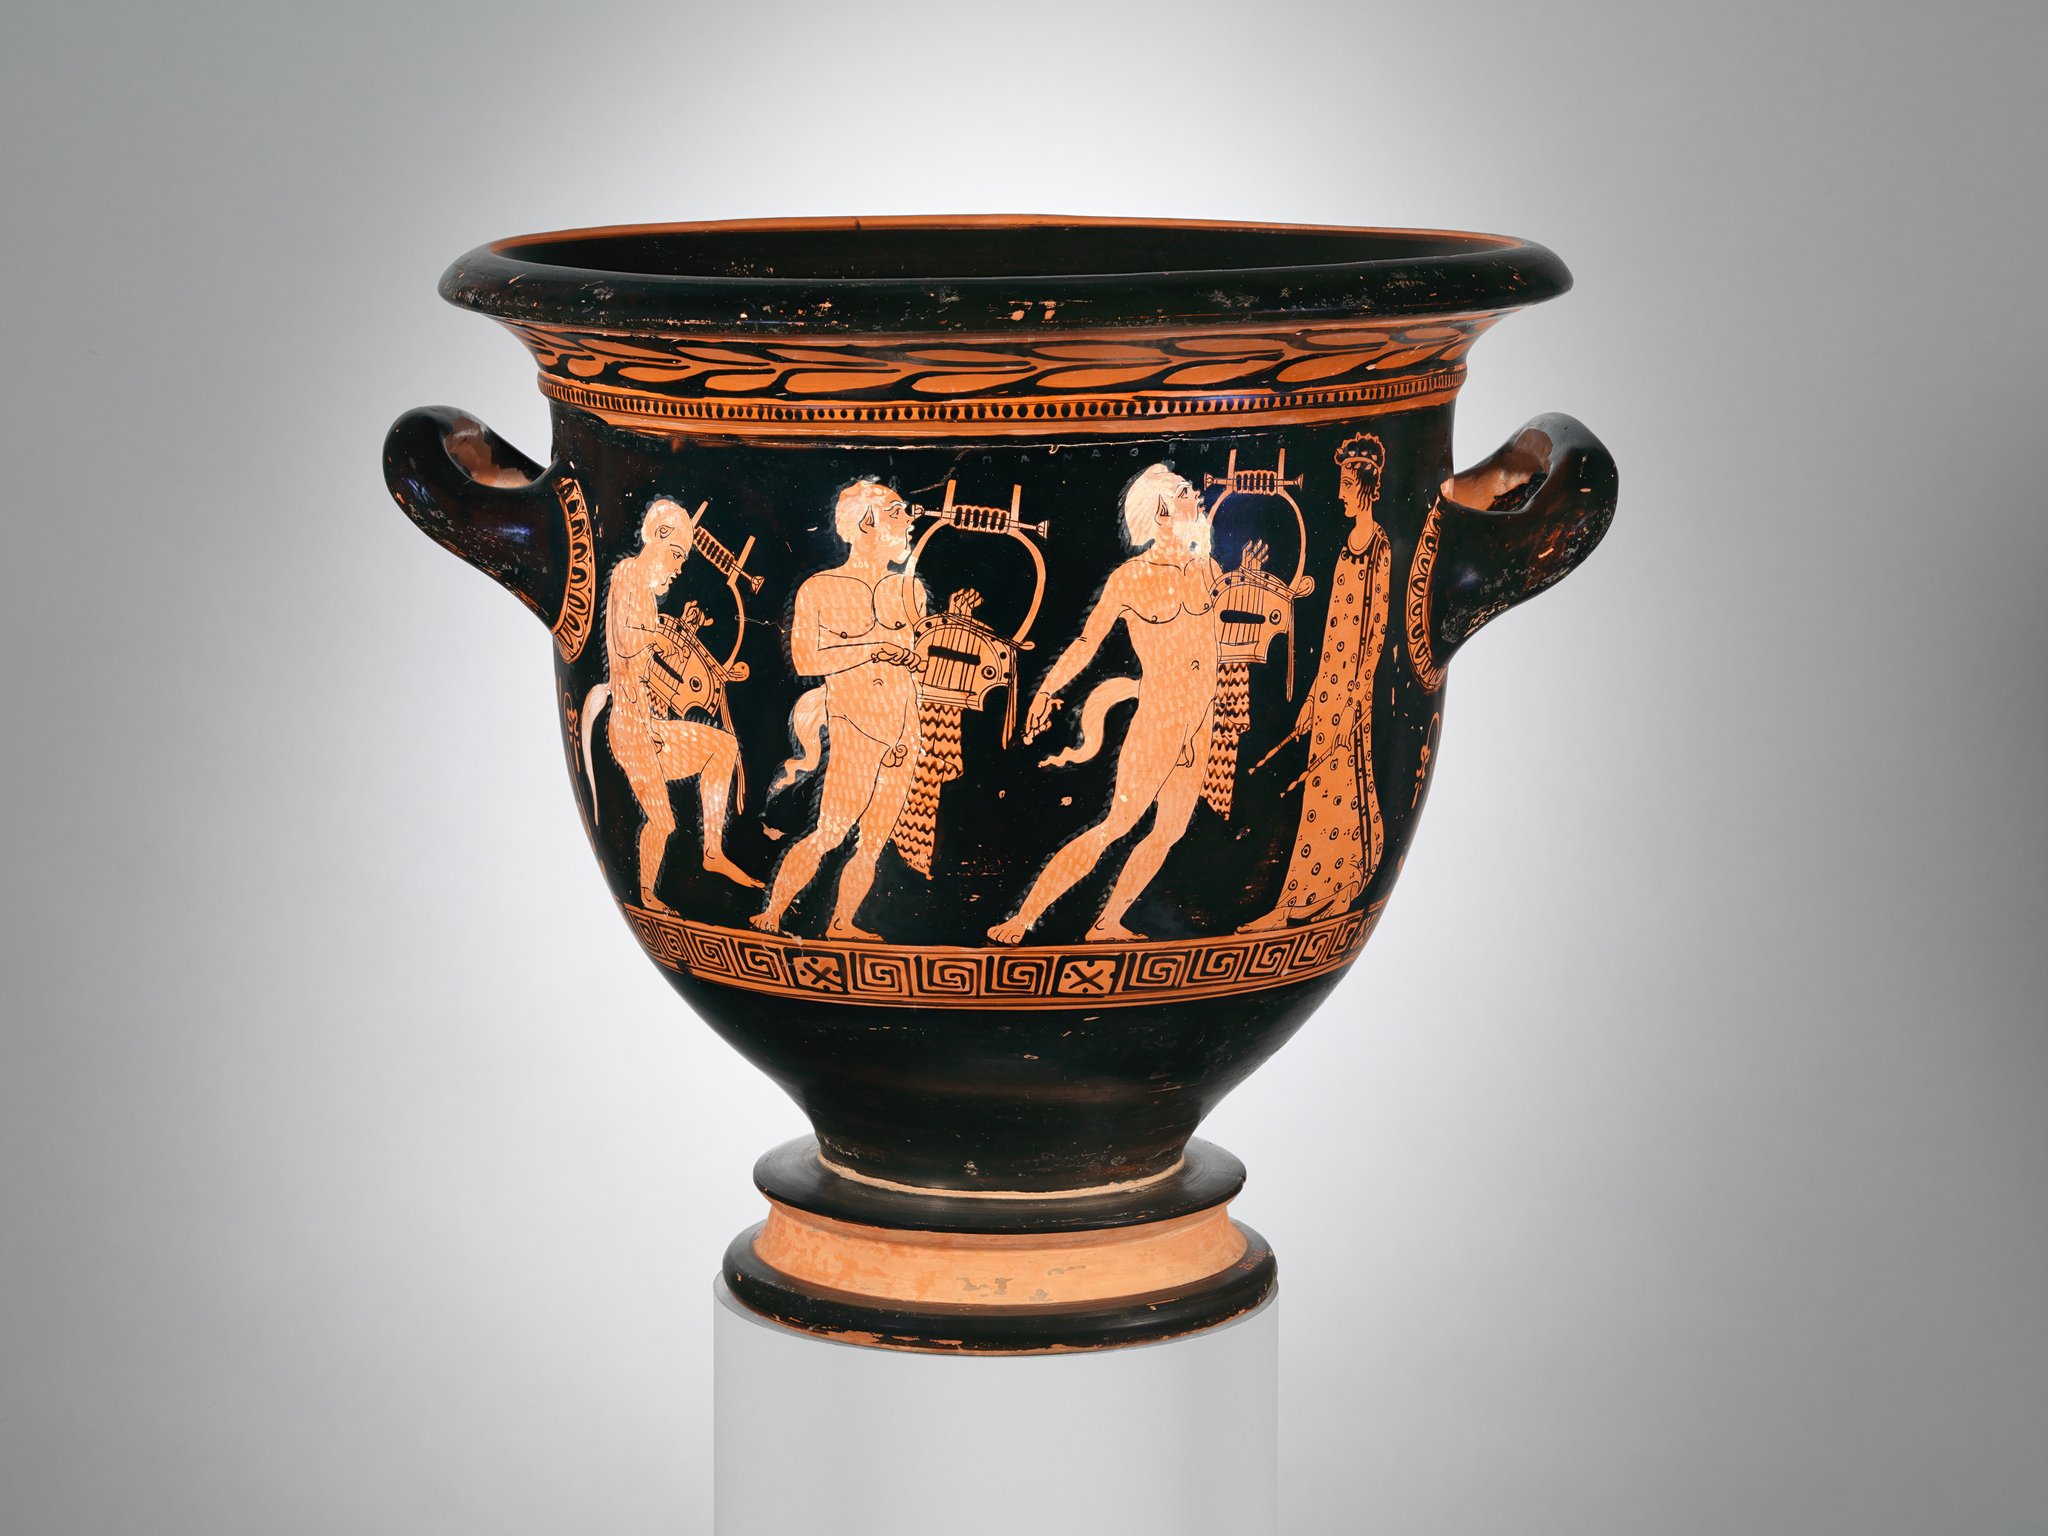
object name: bell krater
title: Terracotta bell-krater (bowl for mixing wine and water)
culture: greek, attic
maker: polion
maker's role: artist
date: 420 BCE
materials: terracotta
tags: men,satyrs,lyres